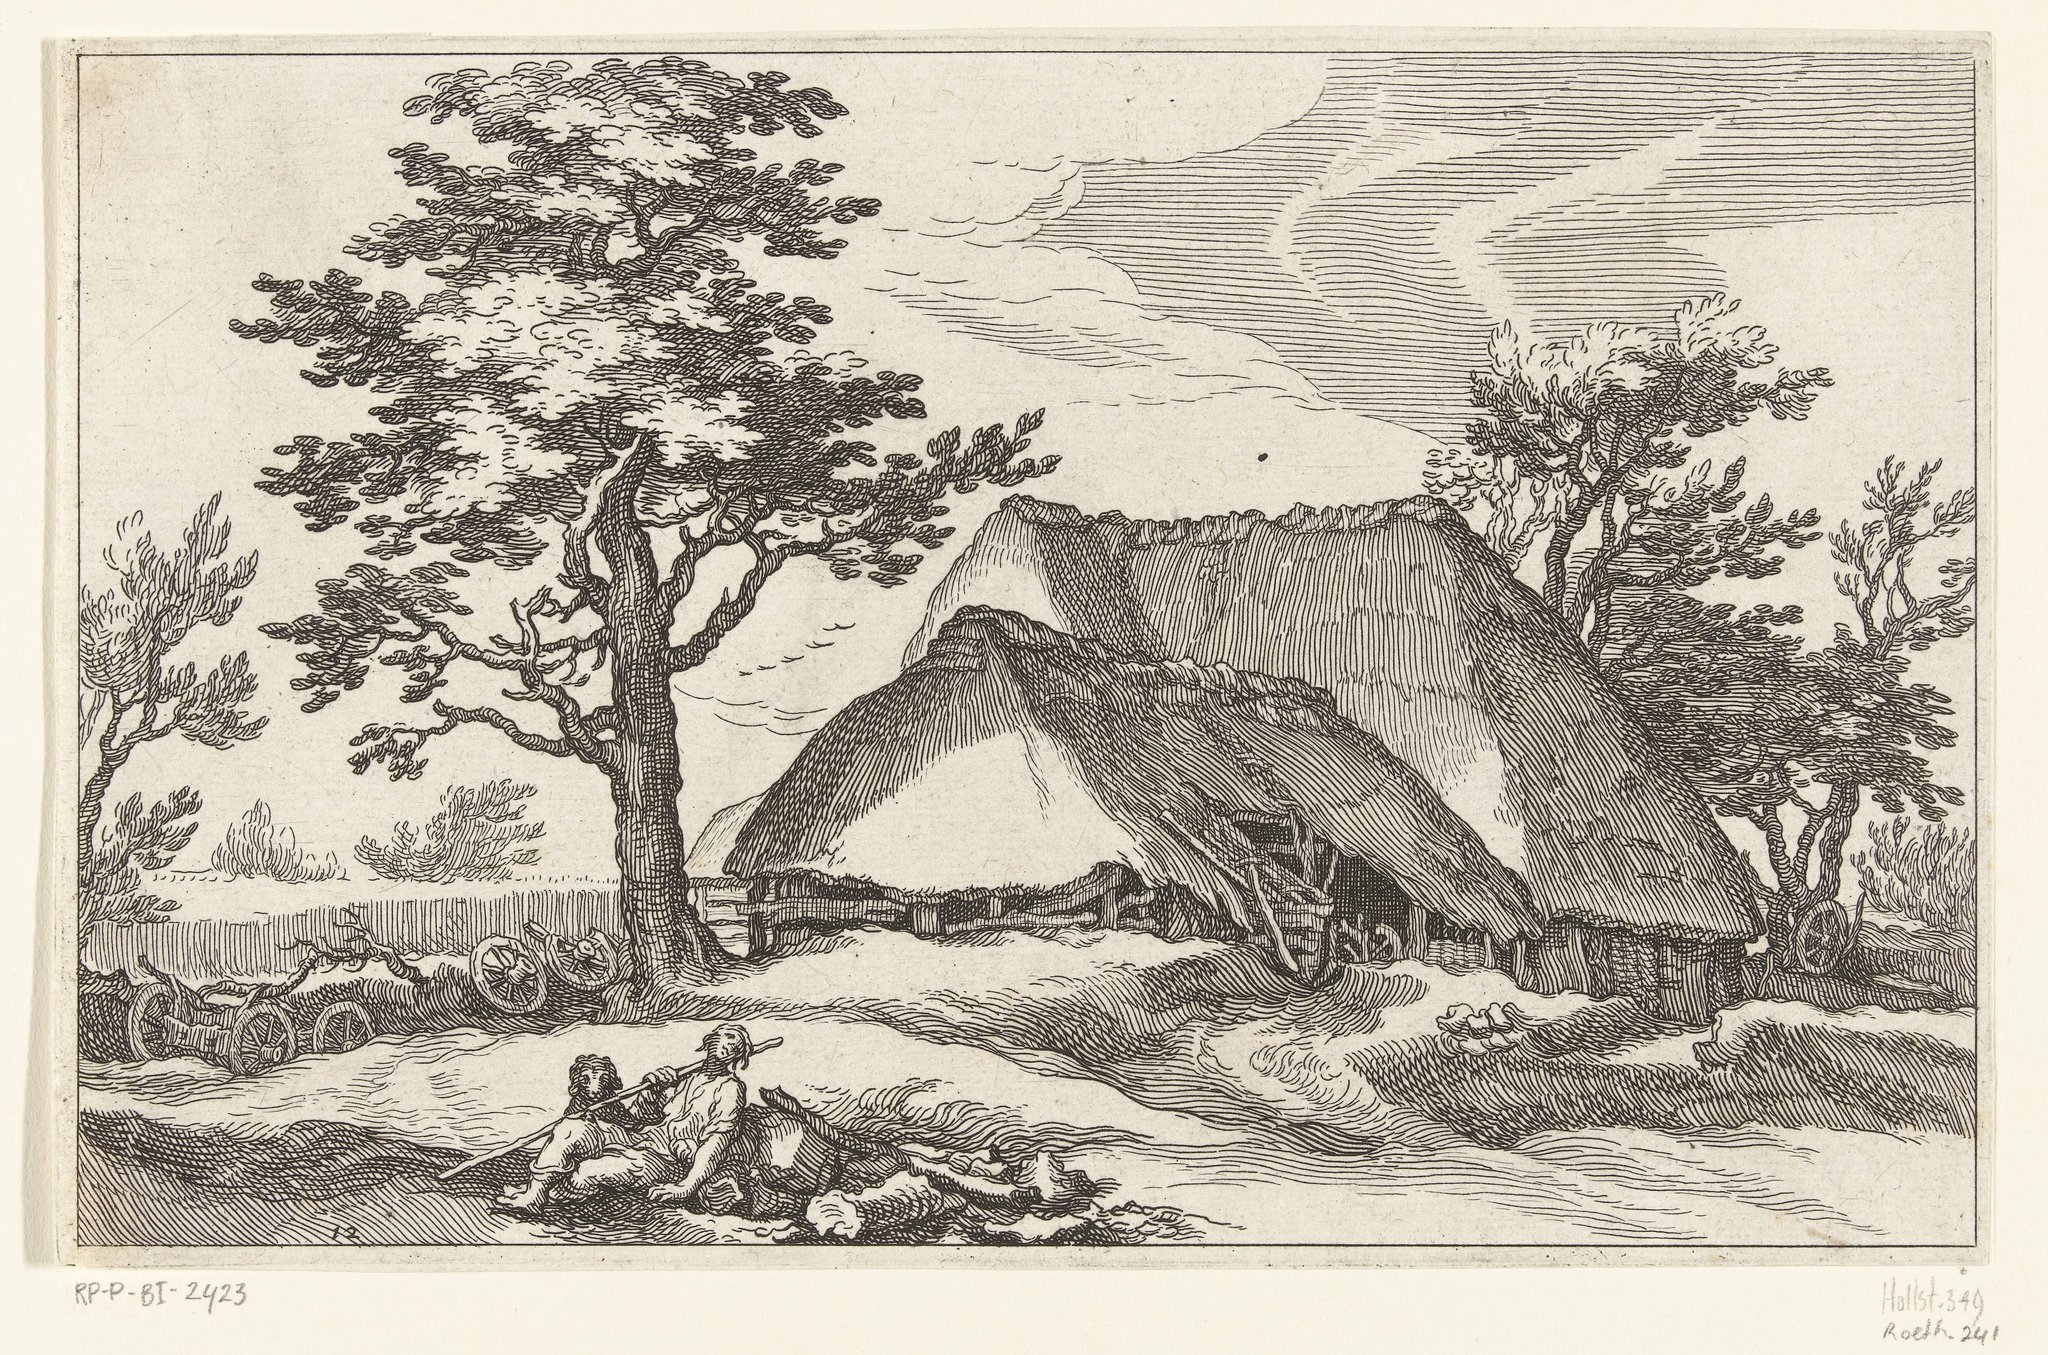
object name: print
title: Landschappen met boerderijen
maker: boëtius adamsz. bolswert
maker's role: print maker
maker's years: 1580-1633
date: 1614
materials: paper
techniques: etching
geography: amsterdam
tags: farm or solitary house in landscape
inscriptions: collector's mark: Lugt 240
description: Prent uit serie van twintig Landschappen met boerderijen naar ontwerp van Abraham Bloemaert.